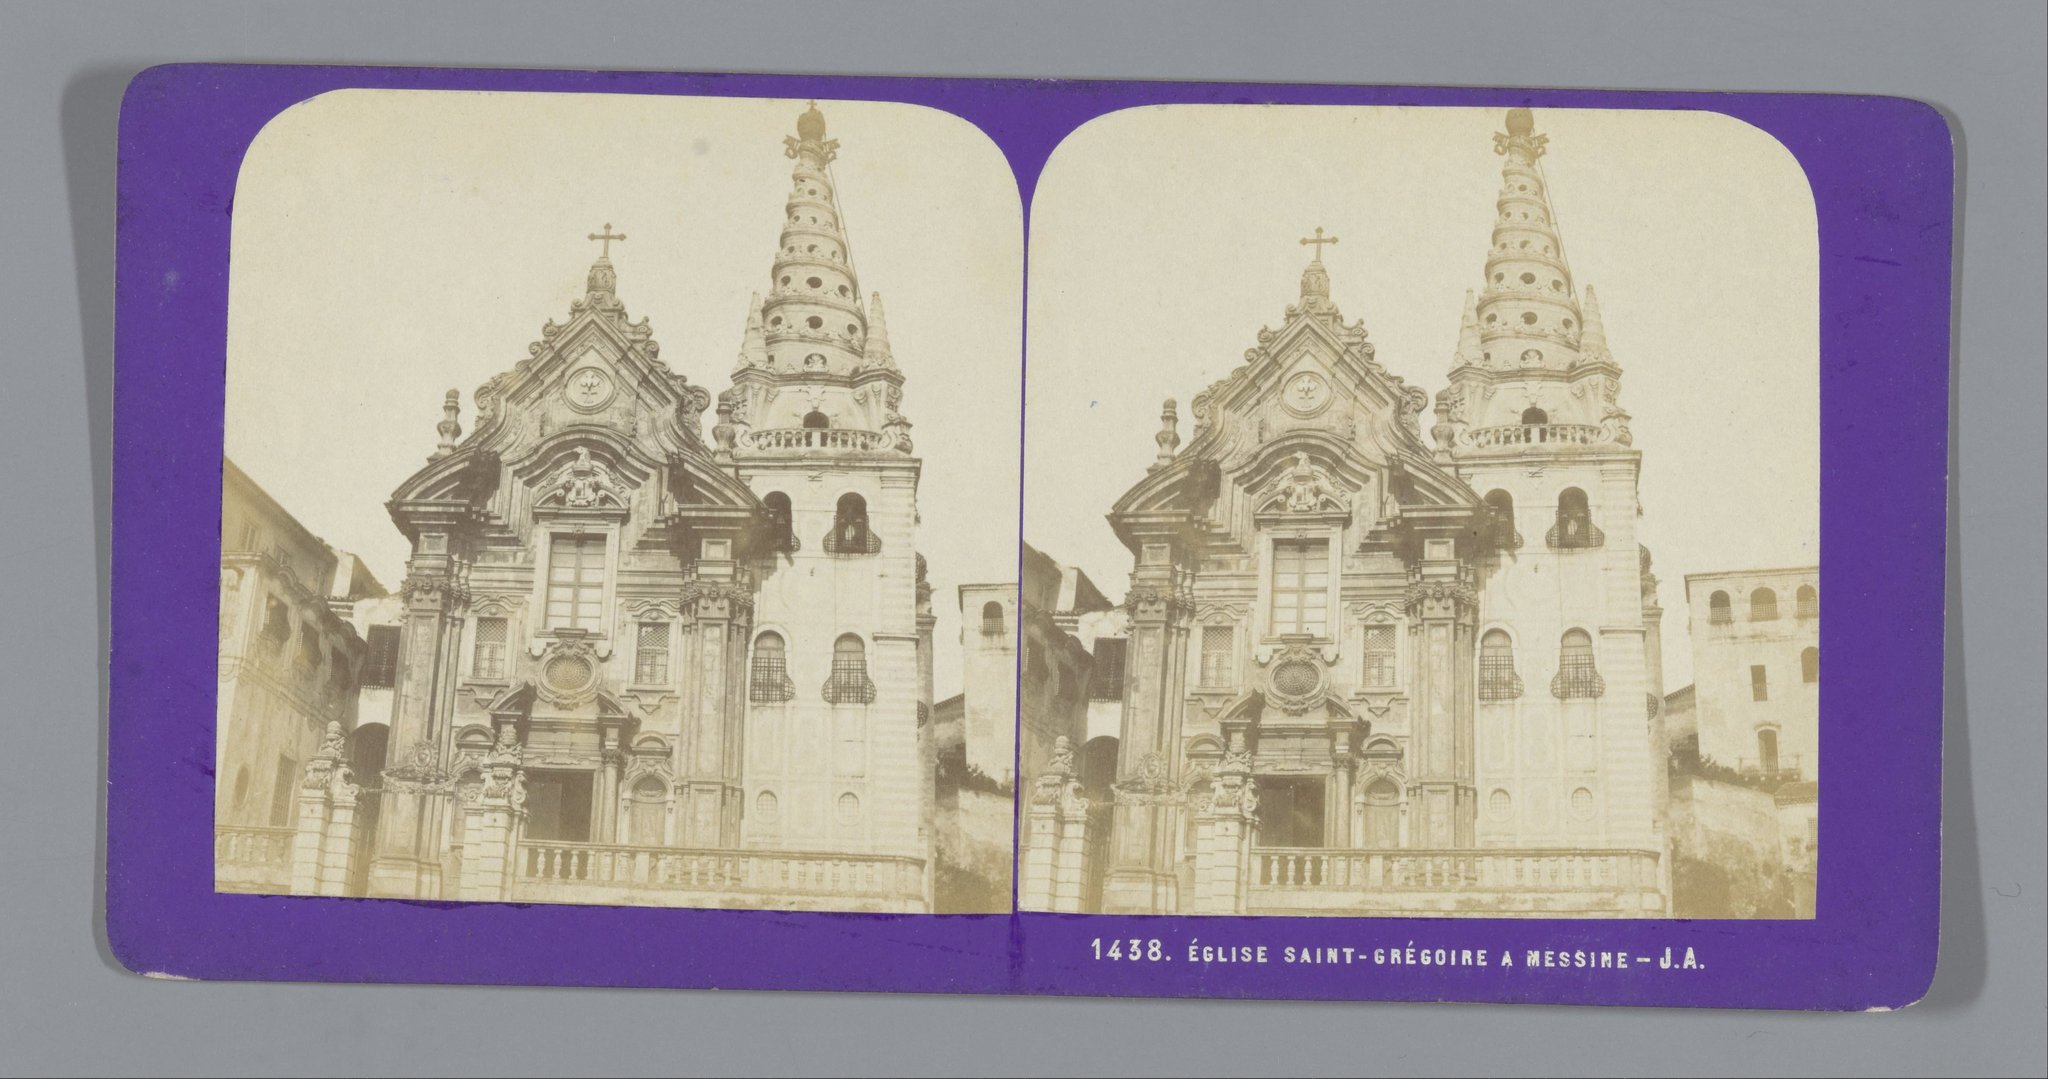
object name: stereograph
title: Église Saint-Grégoire a Messine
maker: jean andrieu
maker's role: fotograaf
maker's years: 1816-1872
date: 1862-1876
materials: cardboard, paper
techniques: albumen print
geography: messina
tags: abbey, monastery, convent ~ roman catholic church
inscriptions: number: ‘1438’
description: Dit gebouw werd vernietigd door een aardbeving in 1908.